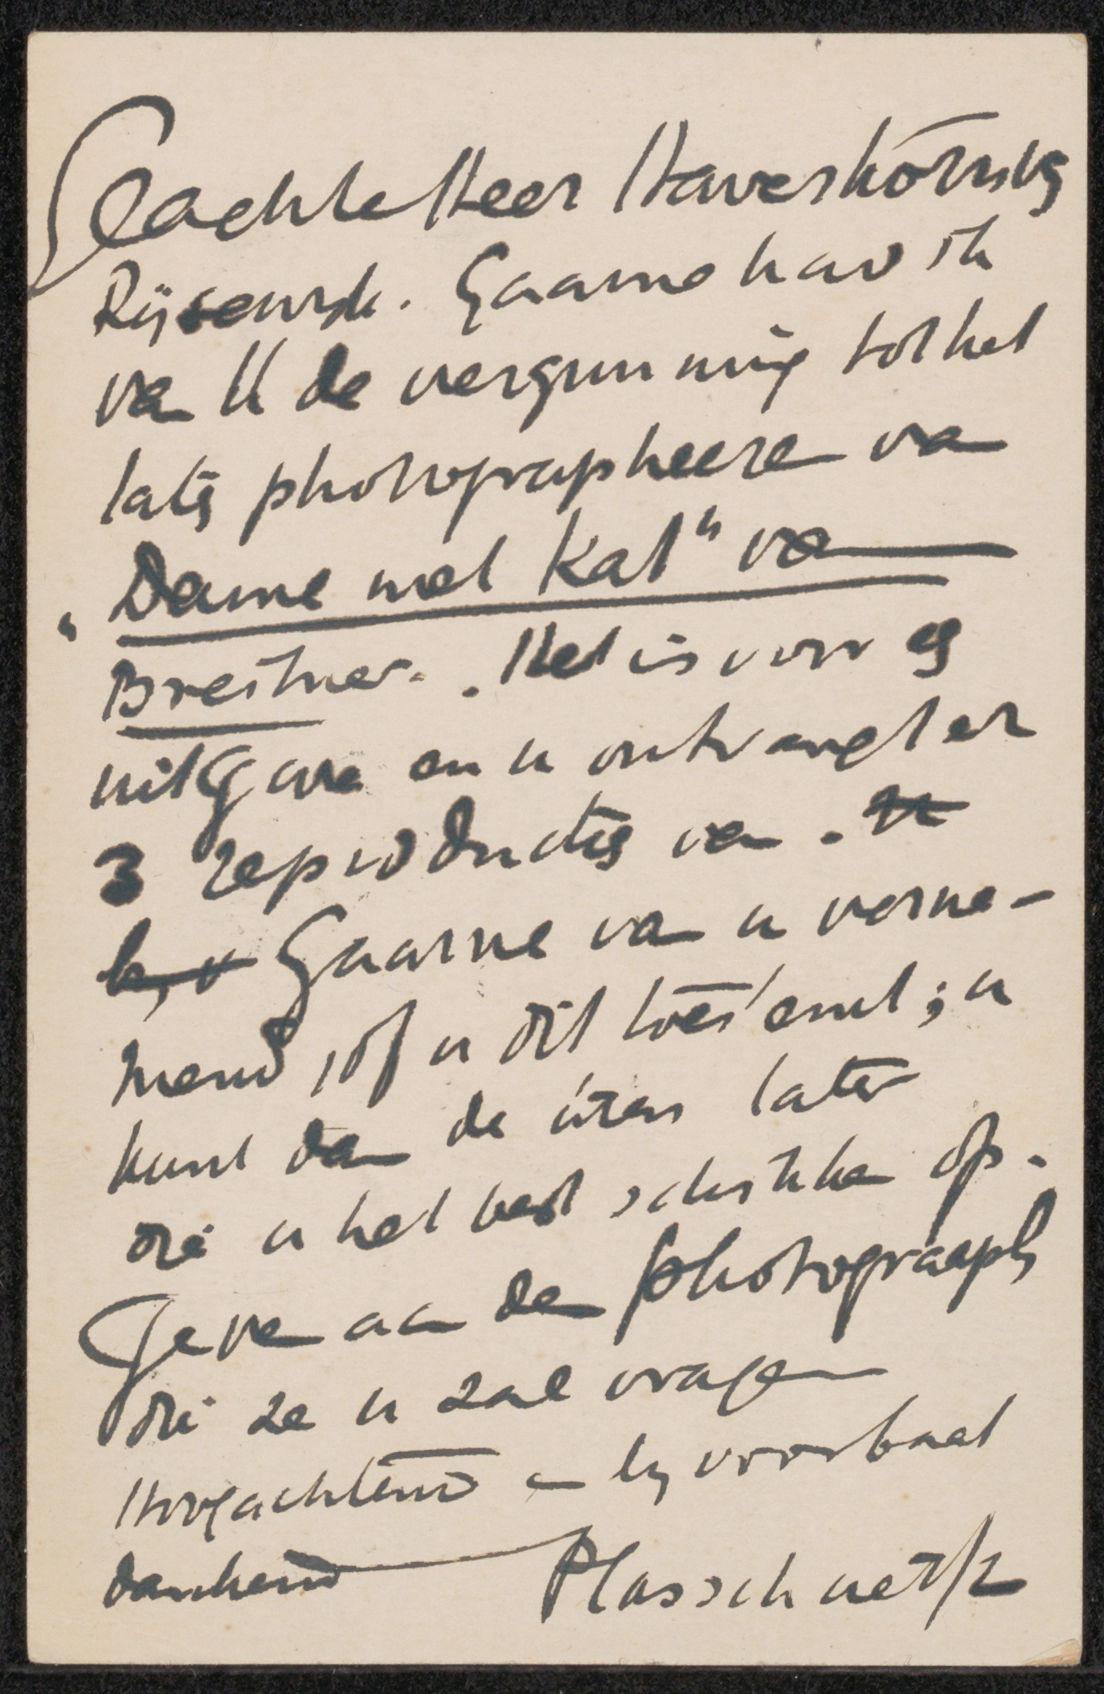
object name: postcard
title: Briefkaart aan Pieter Haverkorn van Rijsewijk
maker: albert plasschaert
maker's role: draughtsman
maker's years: 1866-1941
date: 1910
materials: cardboard, ink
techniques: pen, writing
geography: veere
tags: amsterdam, painter, draughtsman, george hendrik breitner, pieter haverkorn van rijsewijk, photography, cinematography, printed matter